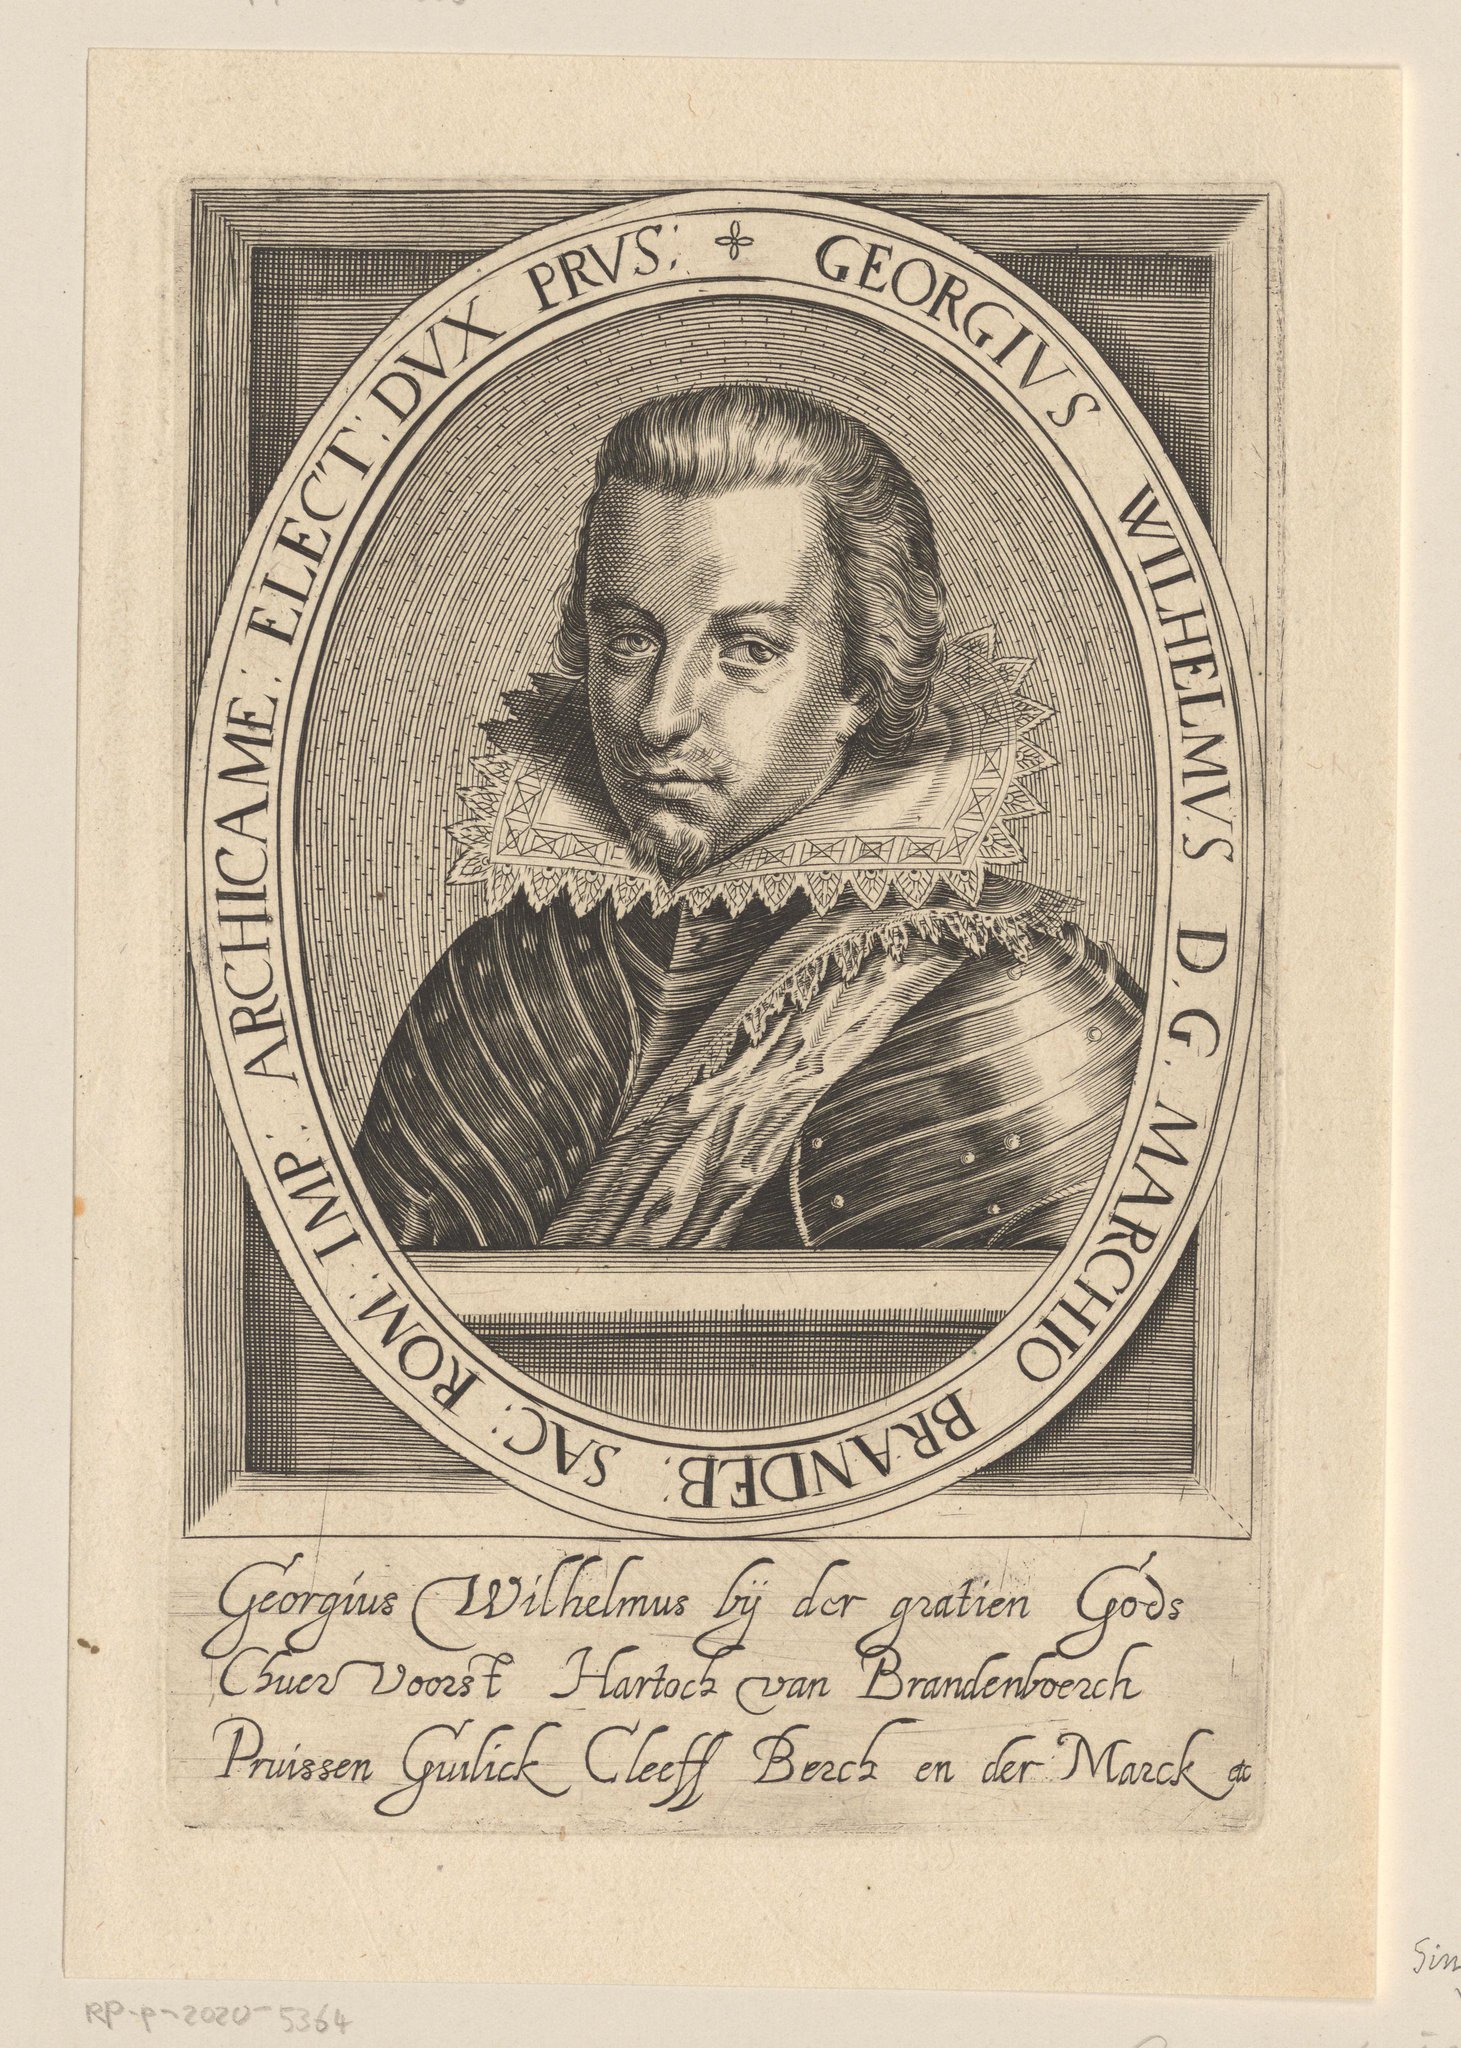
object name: print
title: Portret van Georg Wilhelm van Brandenburg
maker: Anonymous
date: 1600-1700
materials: paper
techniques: engraving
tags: historical persons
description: Tekst in het Latijn in de ondermarge en in de omlijsting.